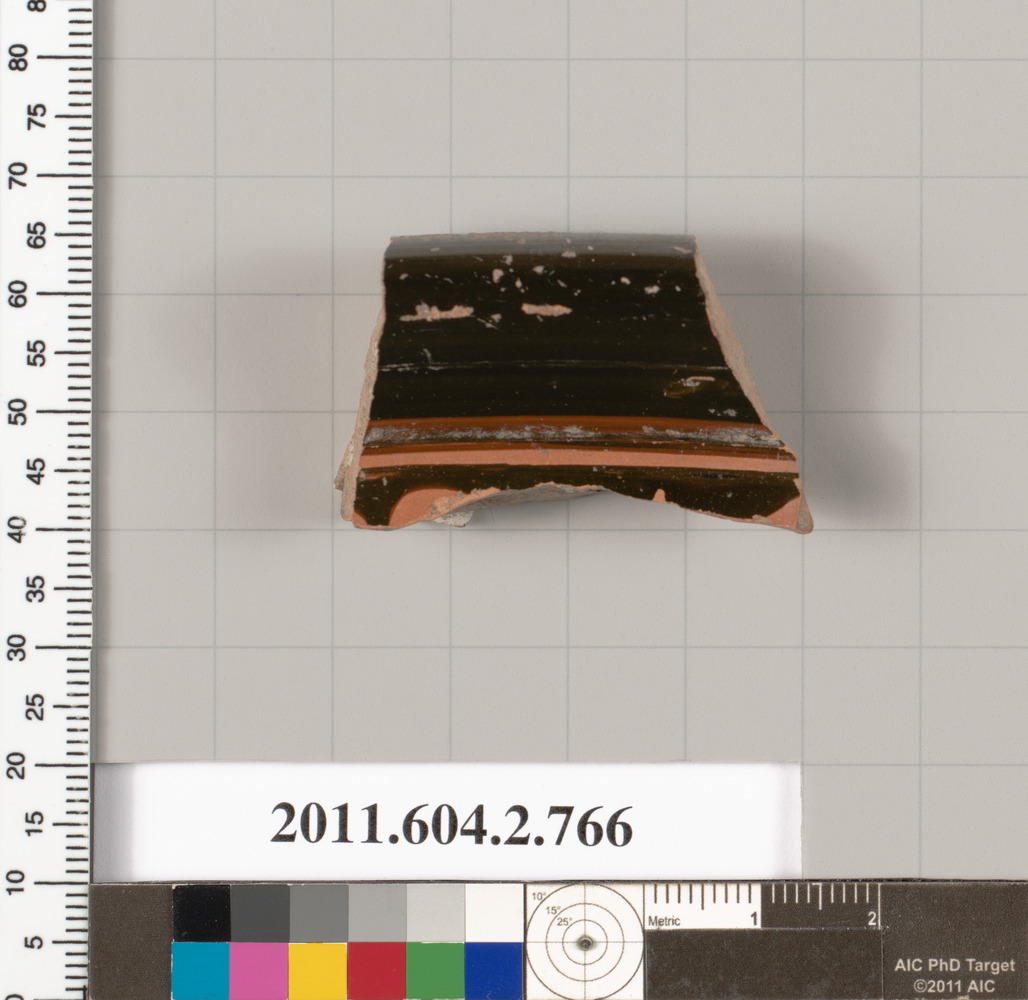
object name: calyx krater fragment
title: Terracotta fragment of a calyx-krater (bowl for mixing wine and water)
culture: greek, attic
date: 500-476 BCE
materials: terracotta